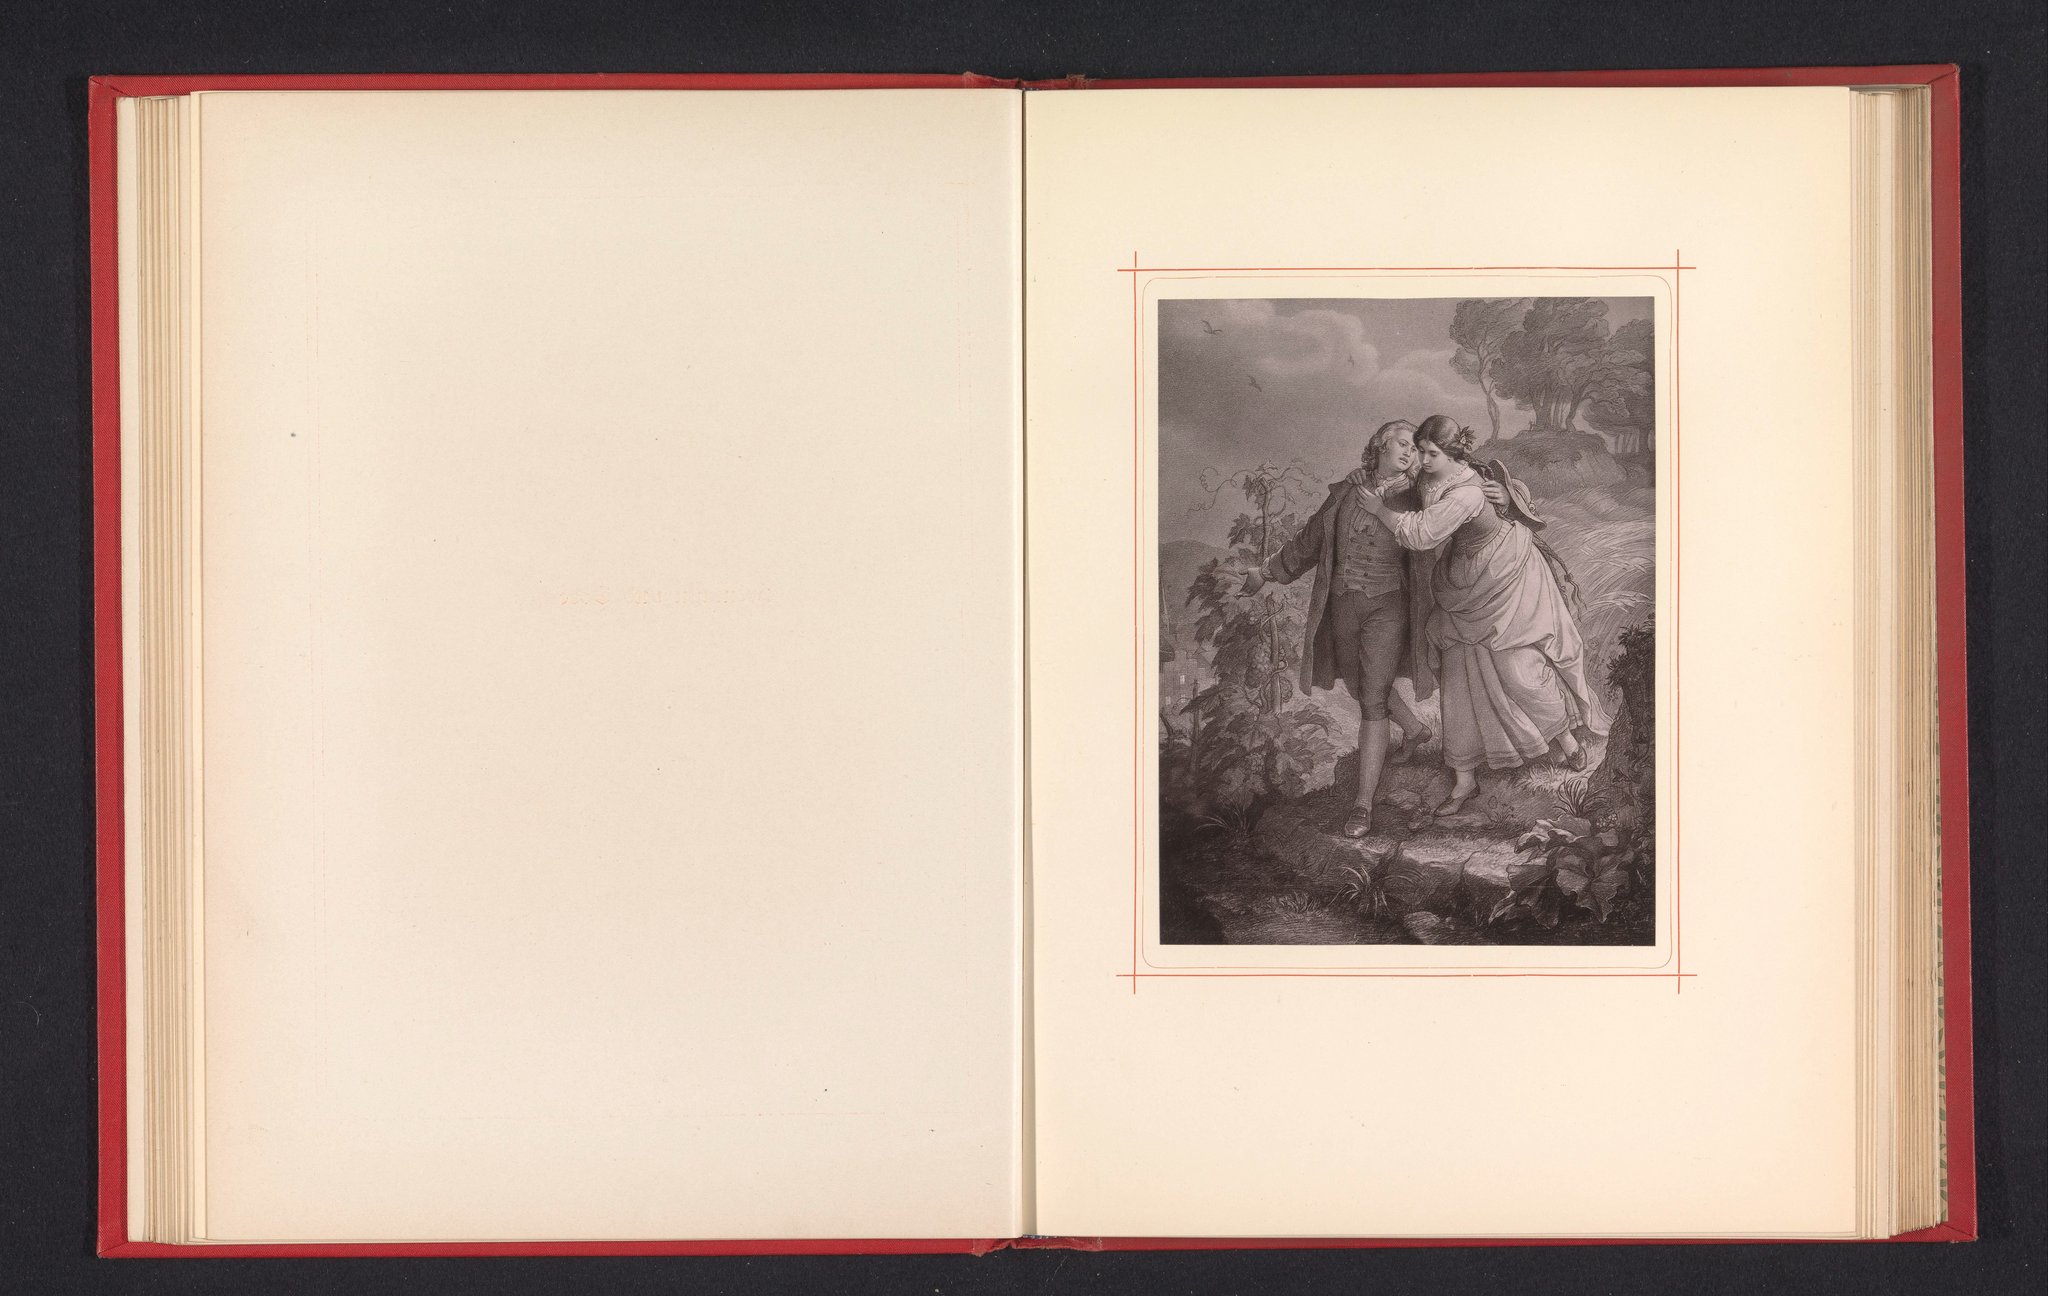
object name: photomechanical print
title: Fotoreproductie van een tekening, voorstellende Hermann en Dorothea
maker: Anonymous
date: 1875-1880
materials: paper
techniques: photograph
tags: lovers' meeting